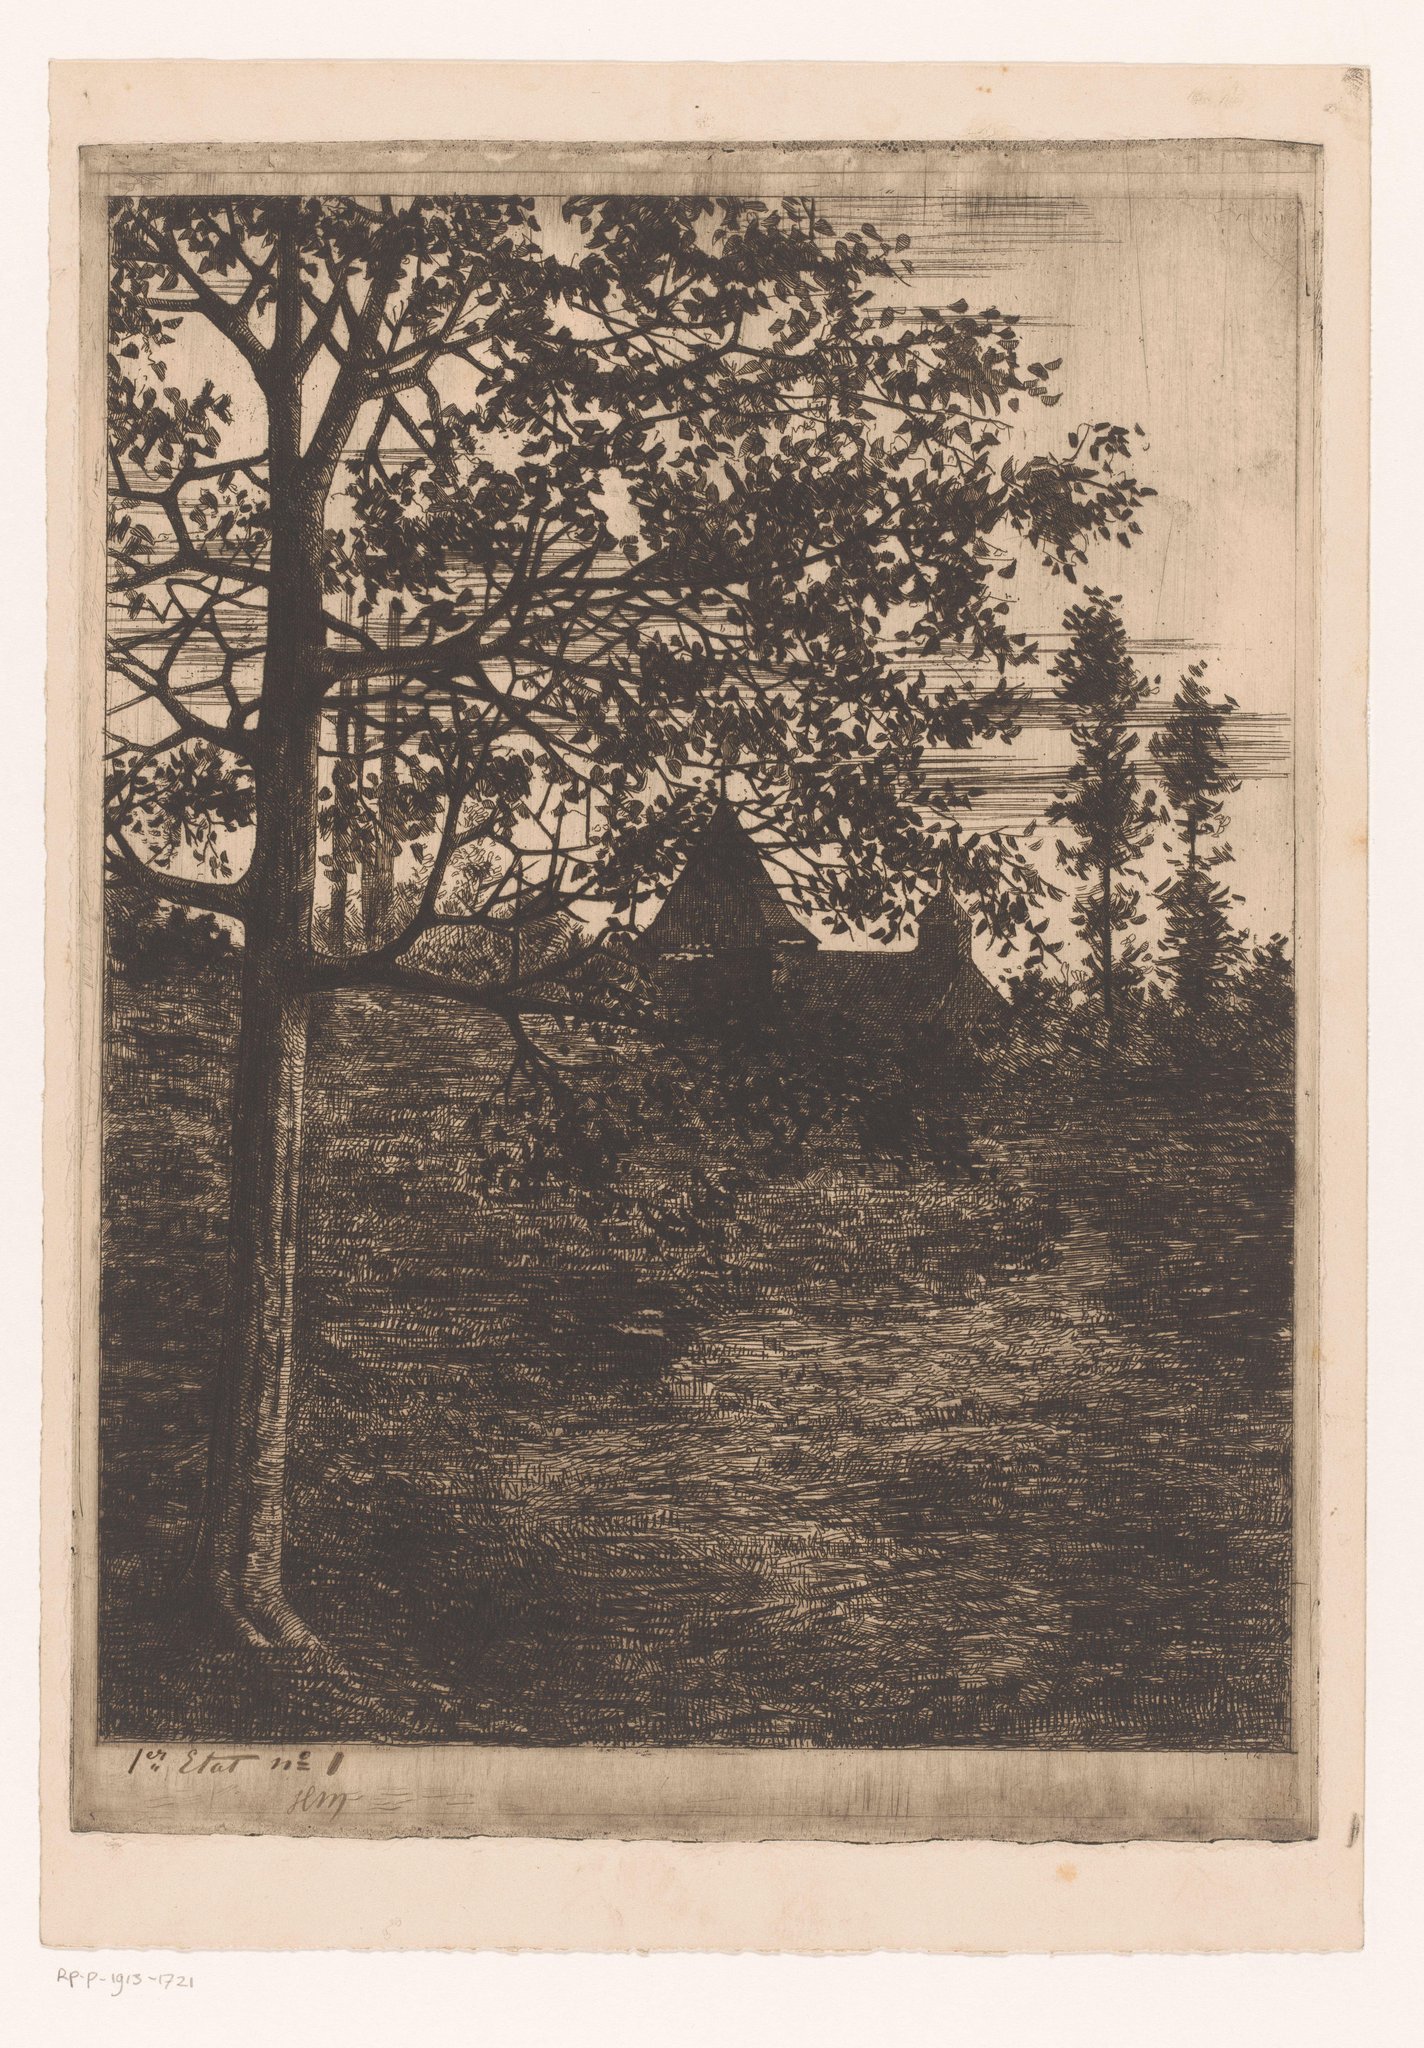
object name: print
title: Landschap met gebouw verscholen achter bebossing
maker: marc henry meunier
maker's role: print maker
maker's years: 1873-1922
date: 1893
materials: paper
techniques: etching, intaglio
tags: city-view, and landscape with man-made constructions, trees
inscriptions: collector's mark: Lugt 2228, inscription: ‘1er Etat No. I’